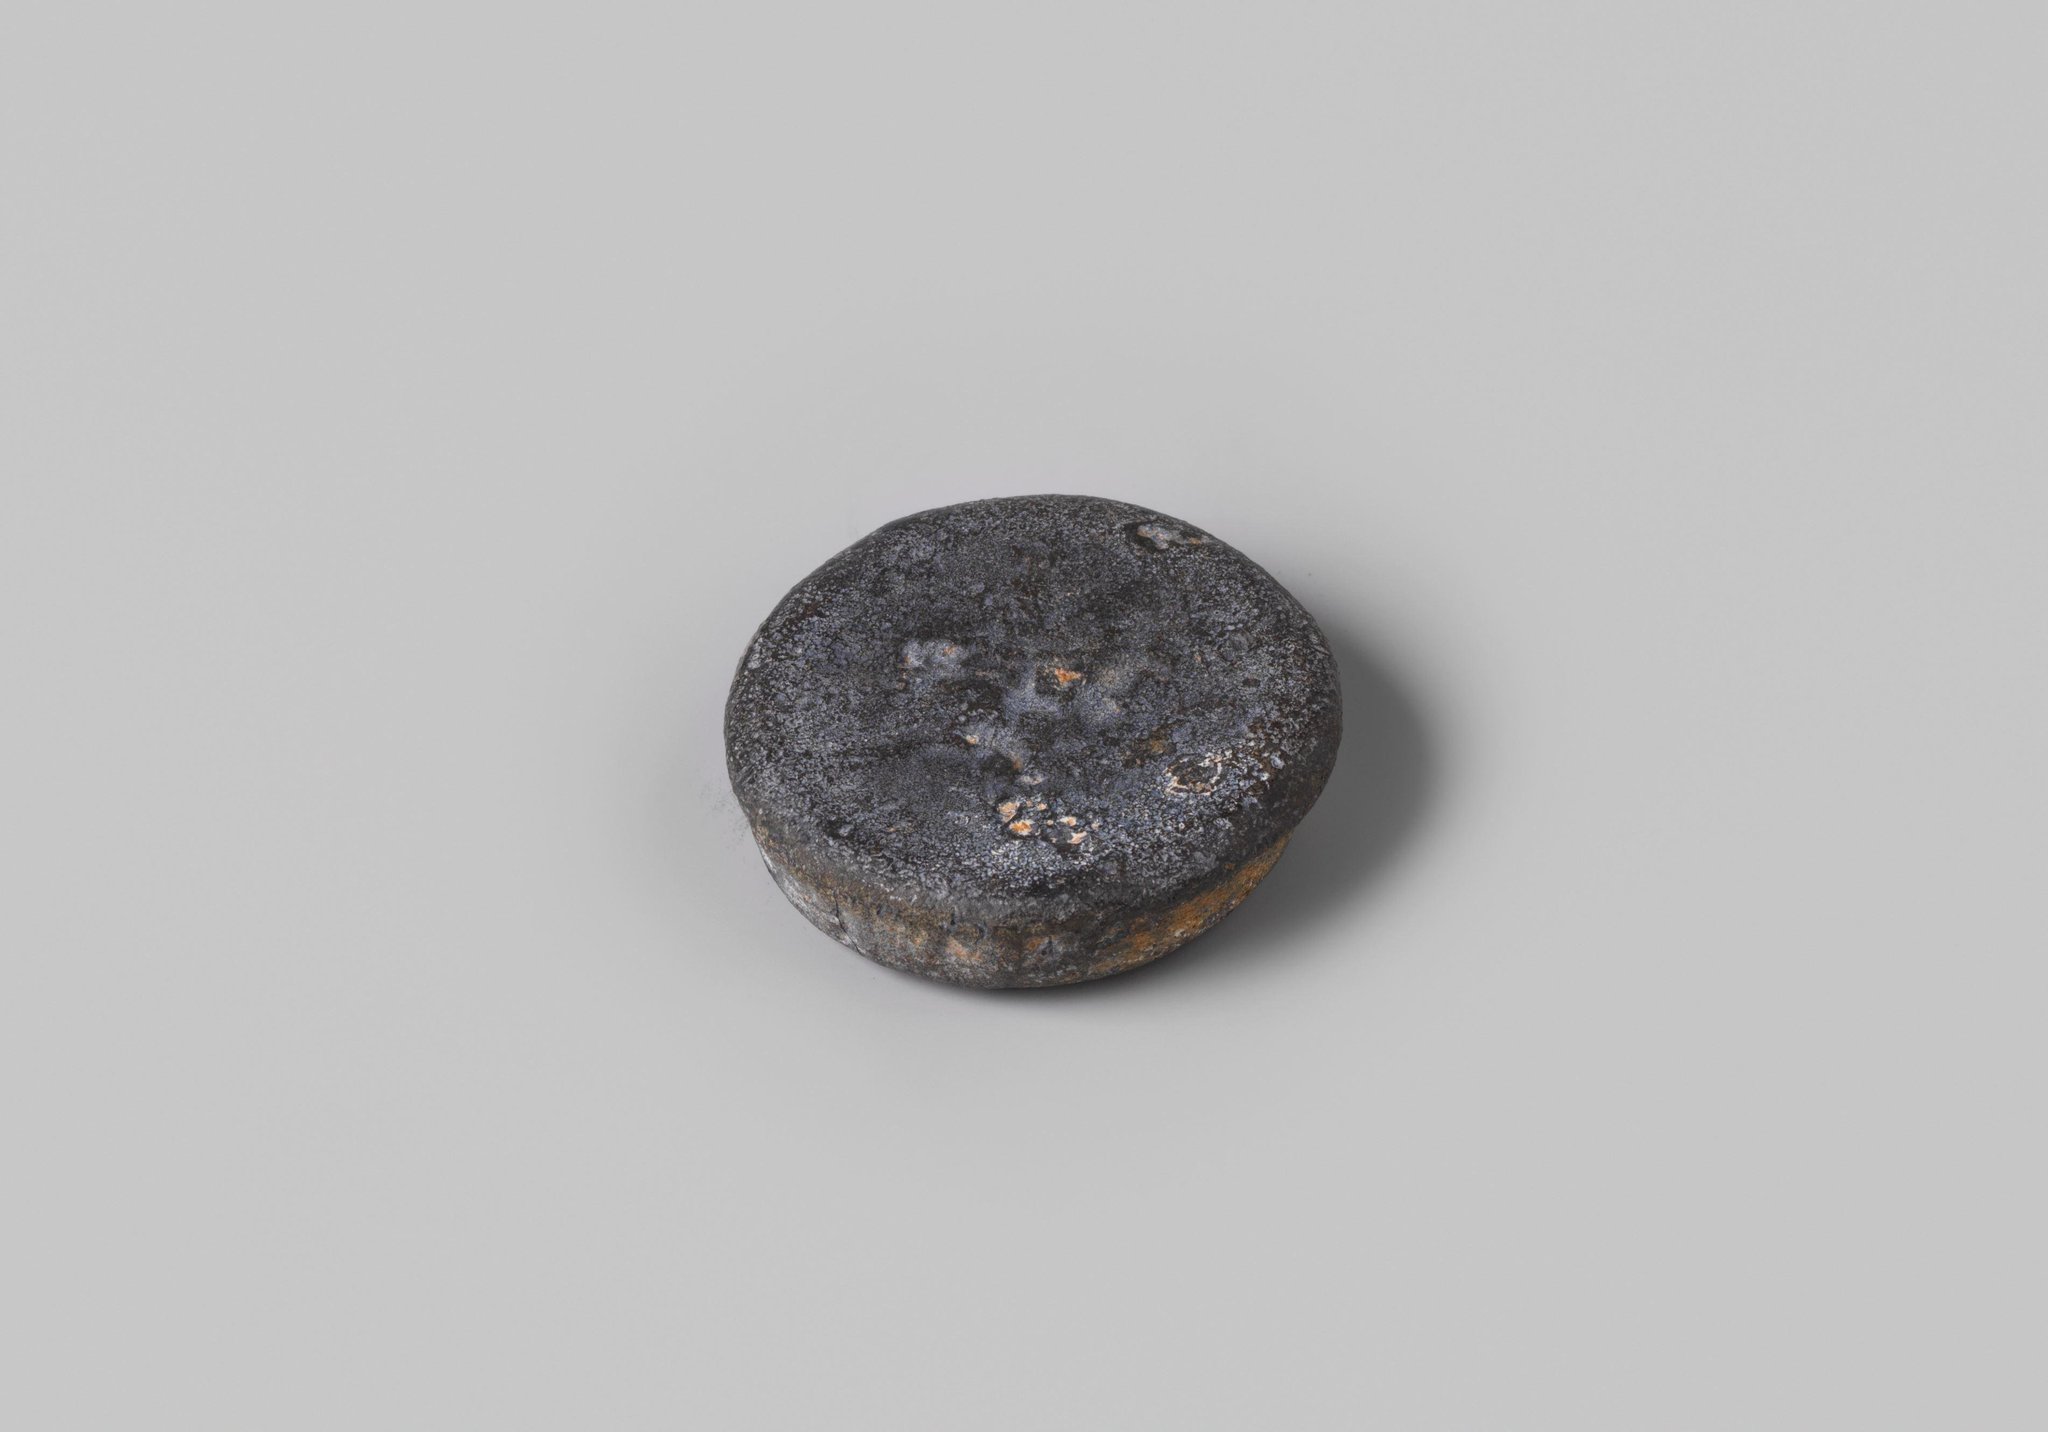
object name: weight scale component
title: Gewicht uit het wrak van de Oost-Indiëvaarder Hollandia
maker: Anonymous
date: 1700-1743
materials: lead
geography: netherlands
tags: verenigde oostindische compagnie, hollandia (schip), annet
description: Disc-shaped weight, circular, flat top and underside, tapering in section.